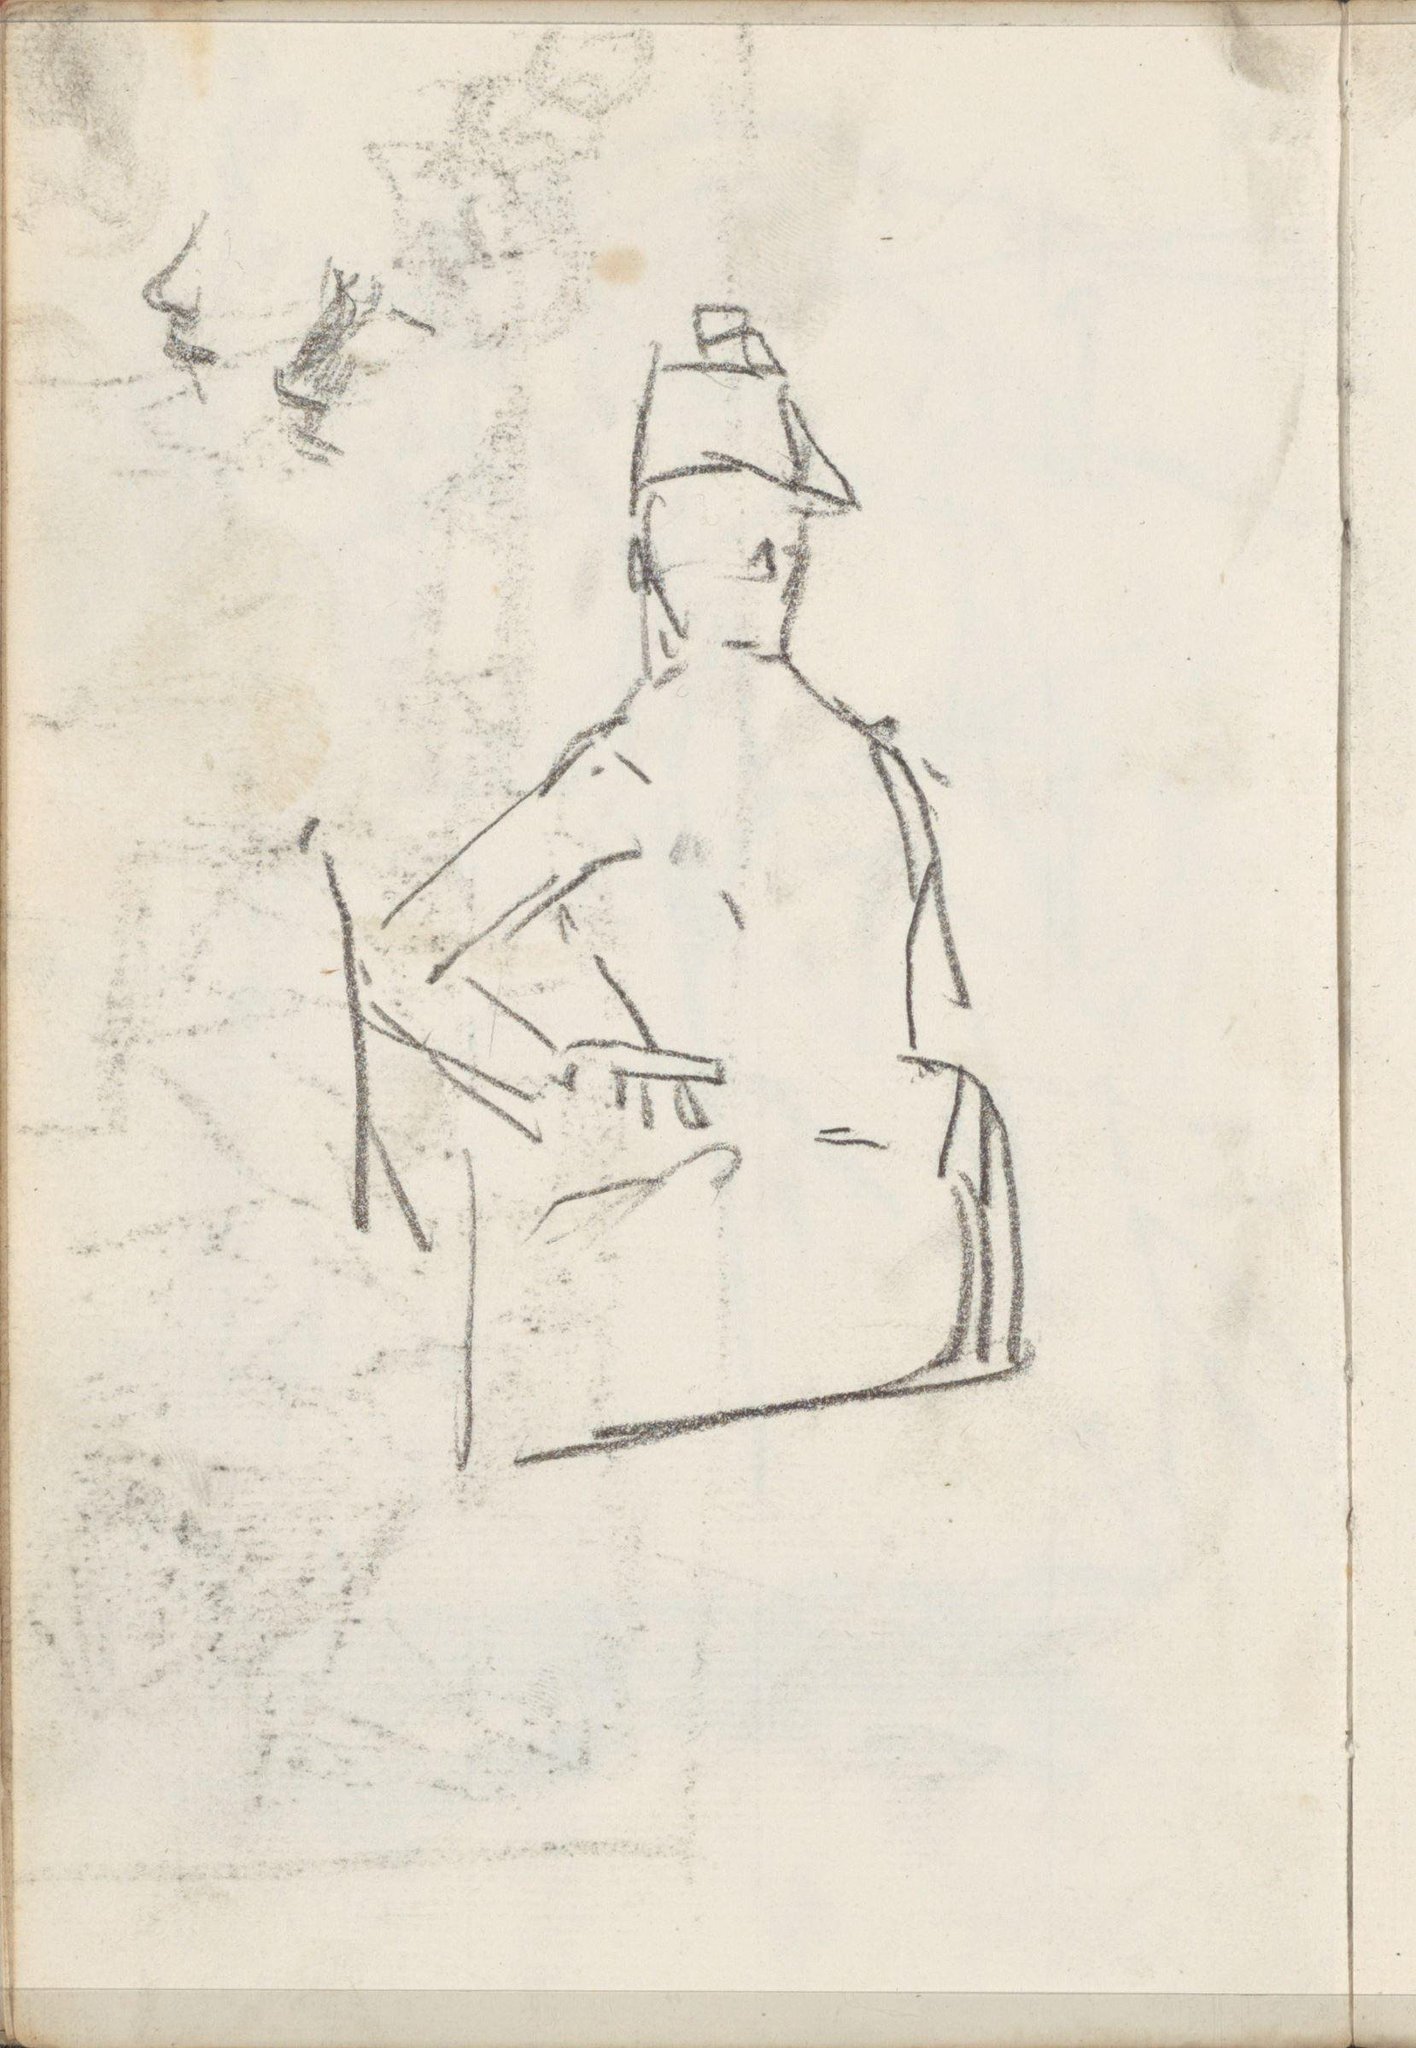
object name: sketchbook leaf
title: Zittende figuur en twee neuzen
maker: george hendrik breitner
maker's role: draughtsman, painter, print maker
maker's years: 1857-1923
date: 1886-1898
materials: chalk, paper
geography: amsterdam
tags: sitting figure, parts of the face: nose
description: Pagina 15 uit een schetsboek met 21 bladen.